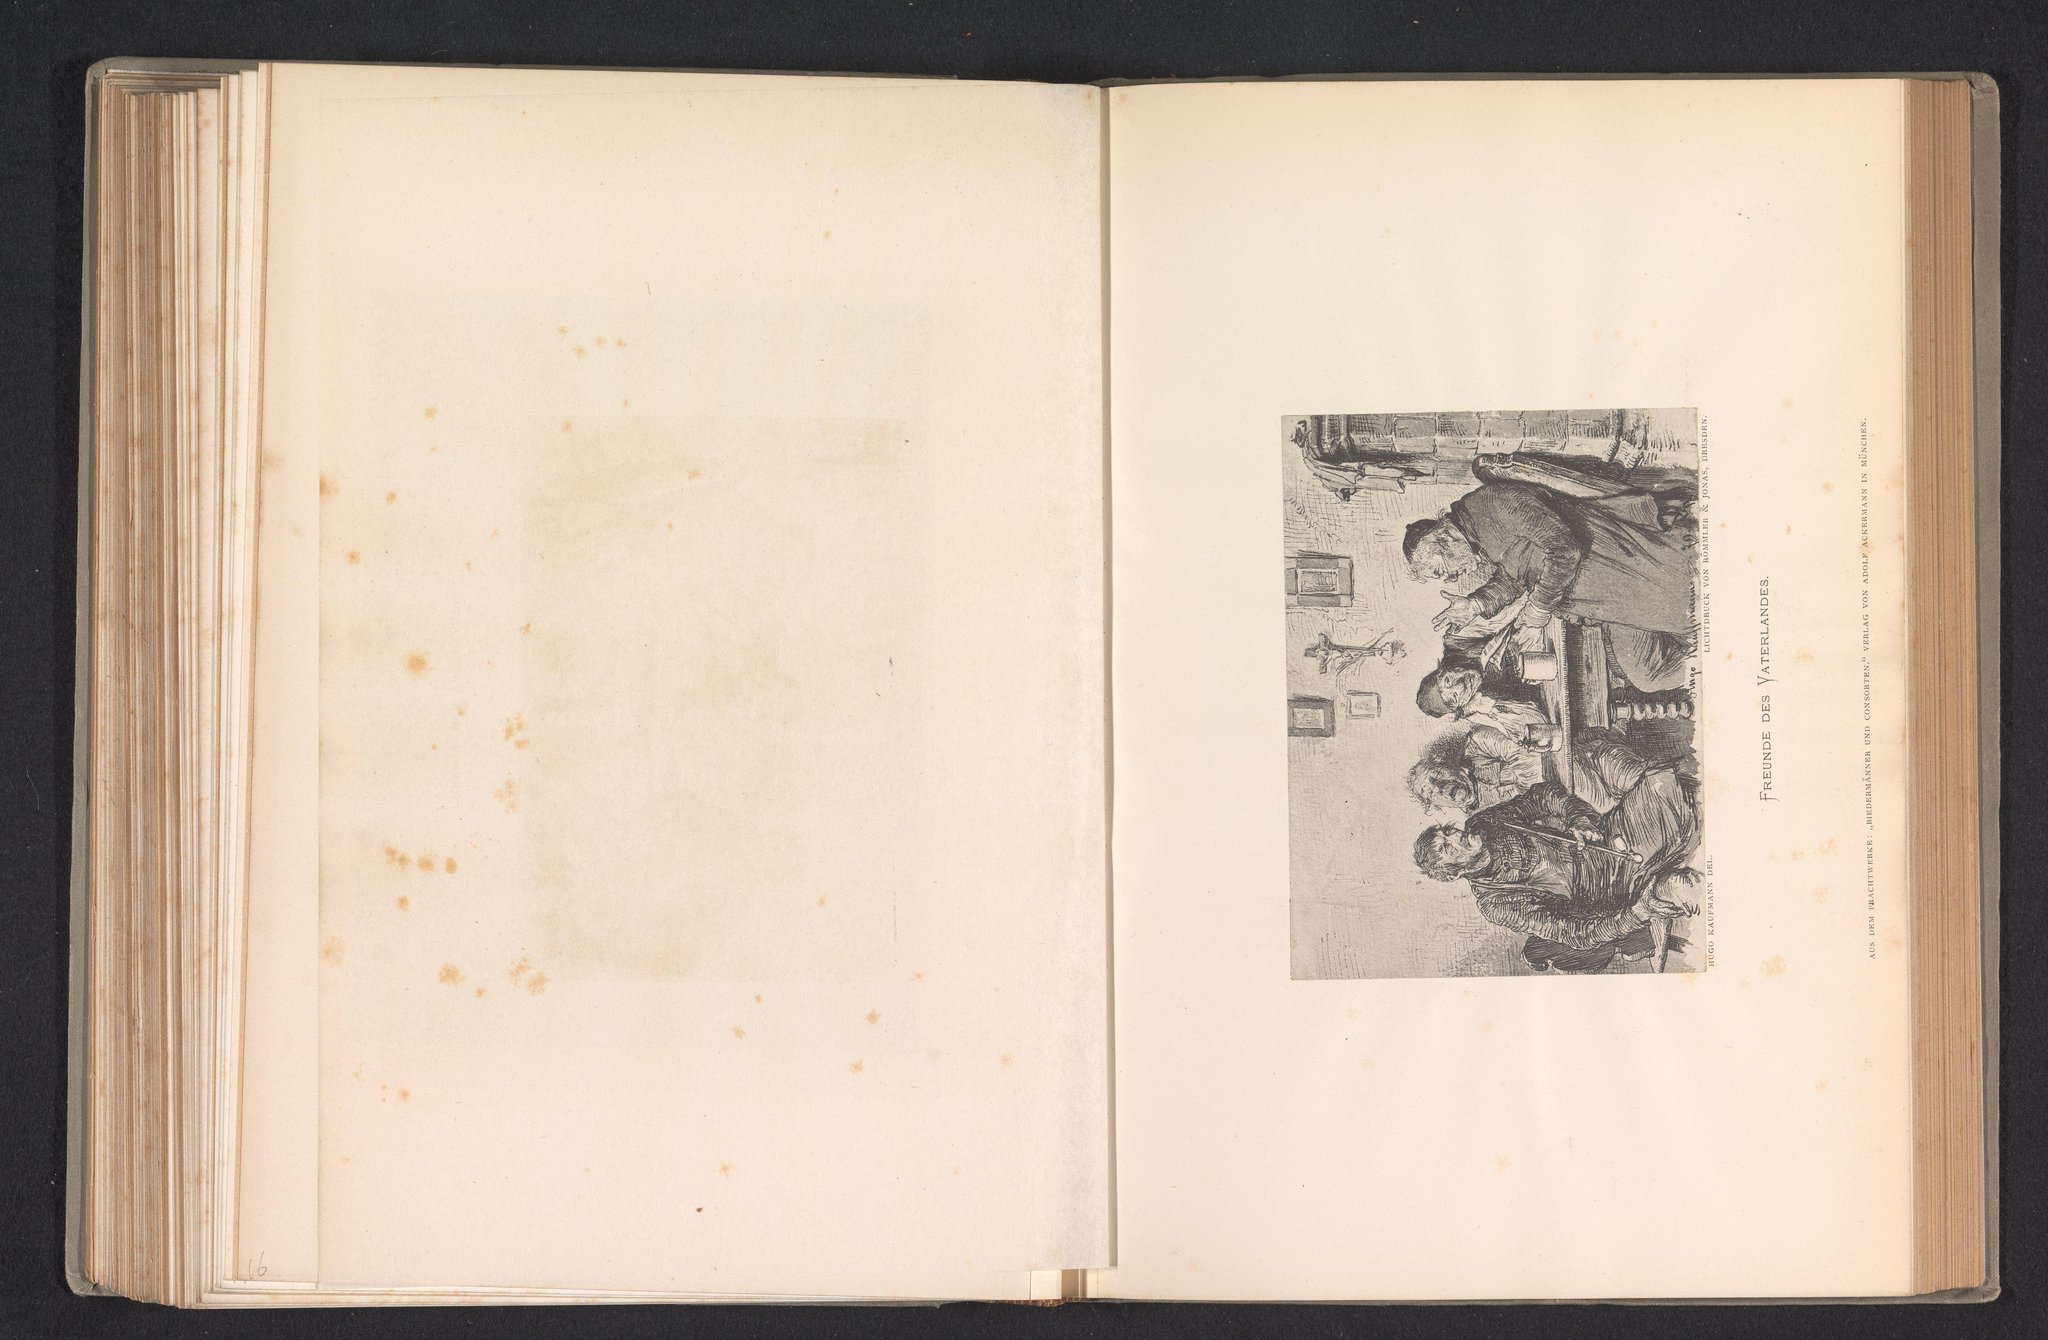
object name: page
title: Freunde des Vaterlandes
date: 1878-1883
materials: paper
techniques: photograph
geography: dresden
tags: adult man, table, interior ~ representation of a building